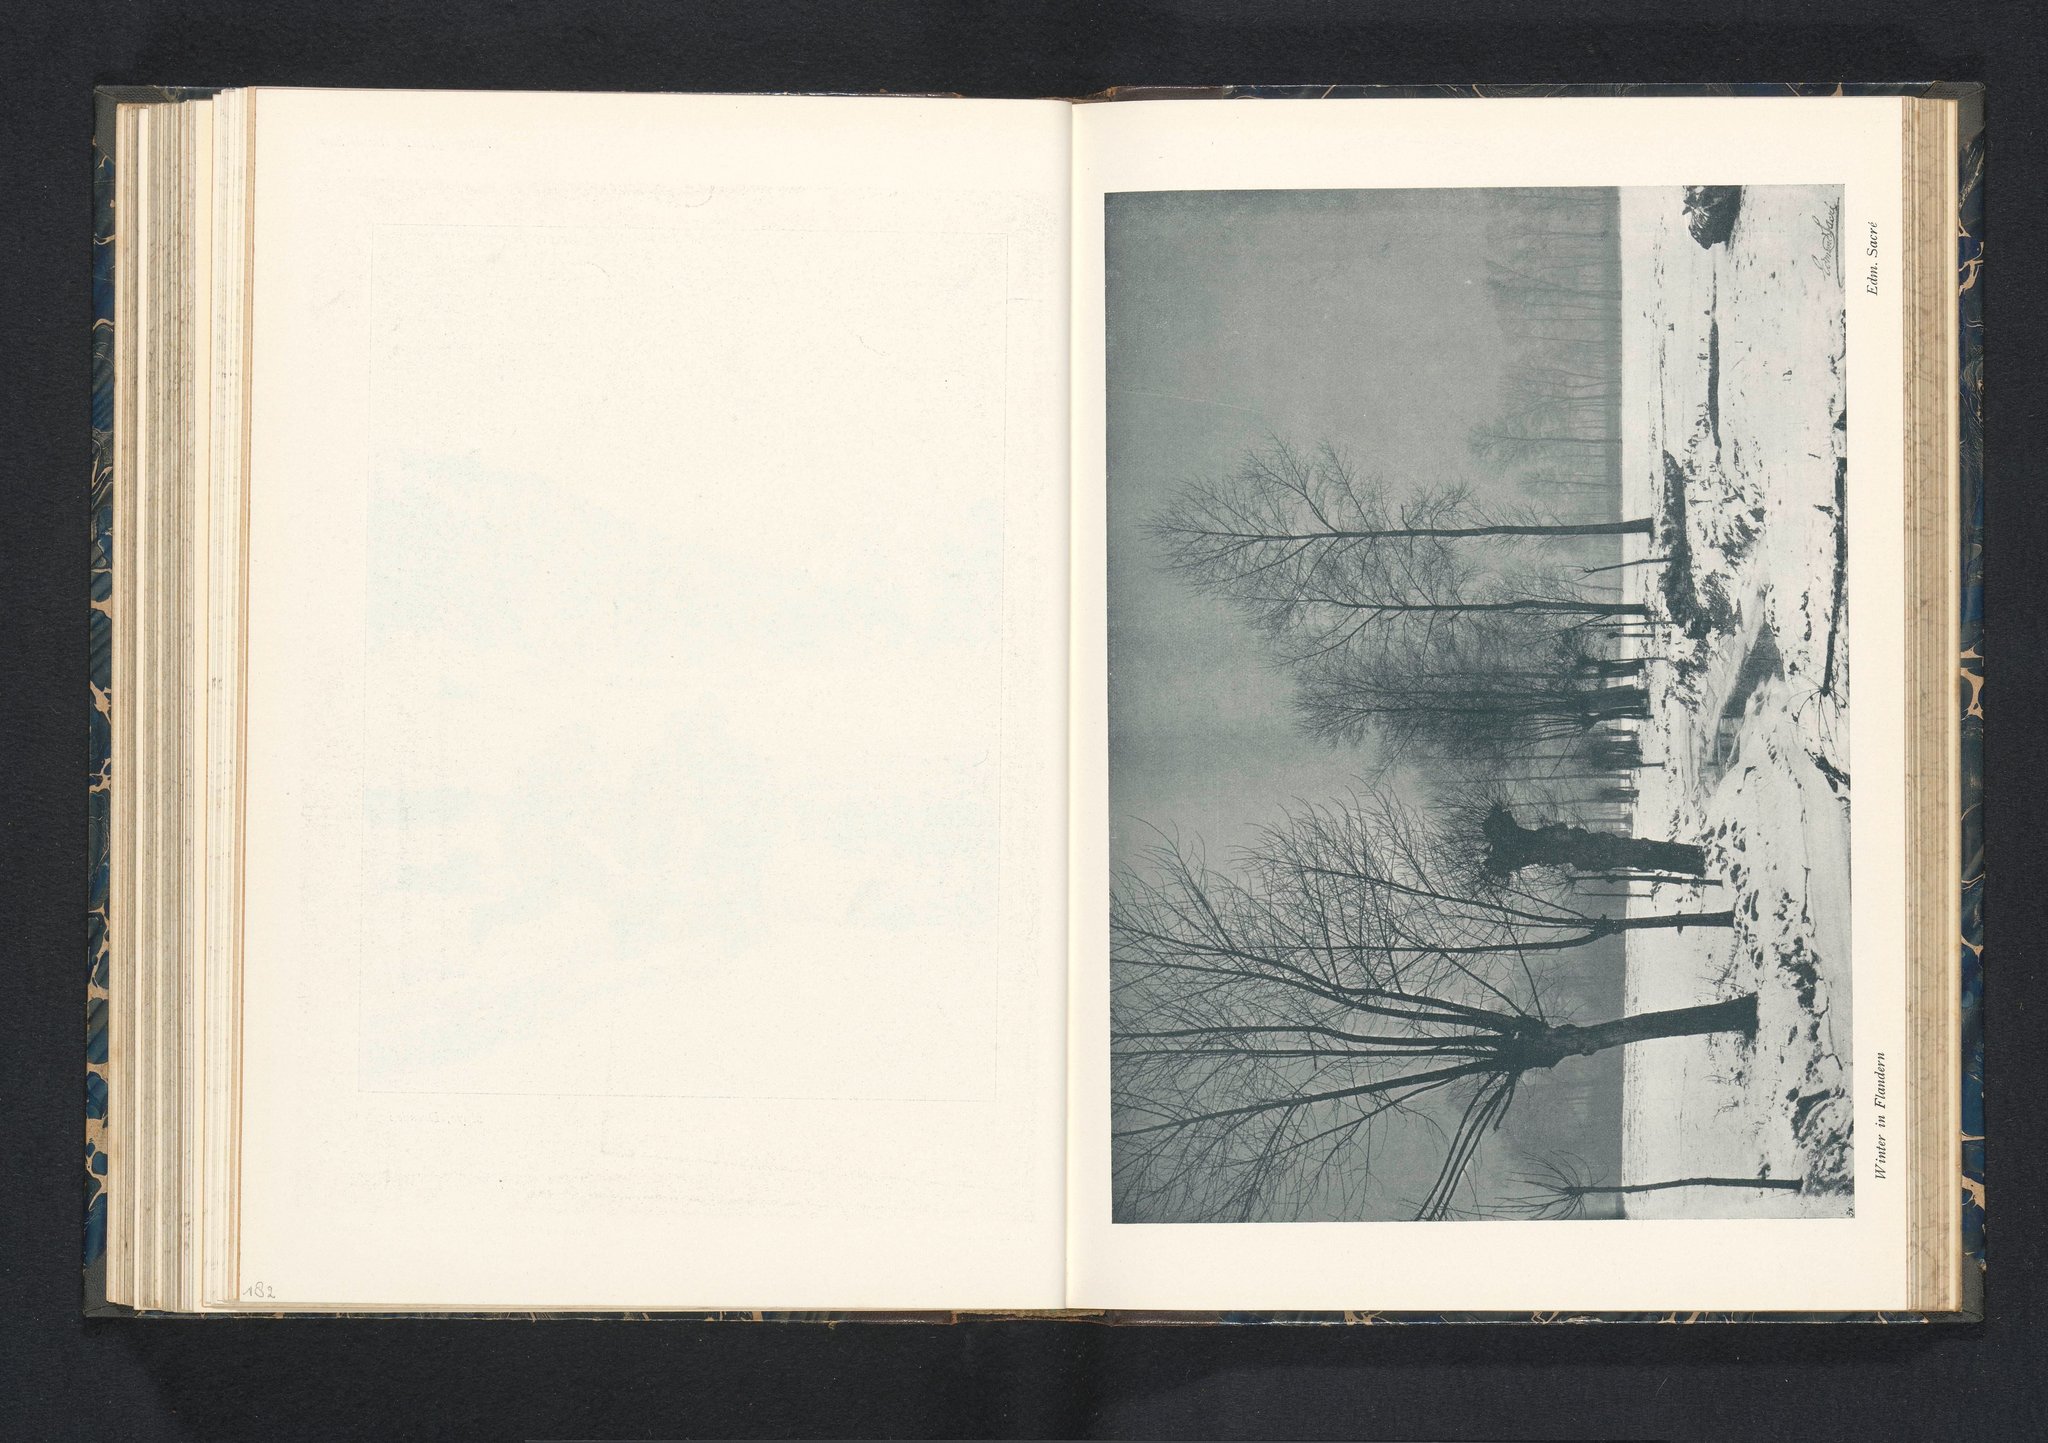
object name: page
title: Winterlandschap in Vlaanderen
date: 1896-1901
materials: paper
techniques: autotype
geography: flanders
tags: landscapes, snow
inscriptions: monogram: ‘BX’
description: Prent op vijfde ongenummerde pagina na pagina 236.